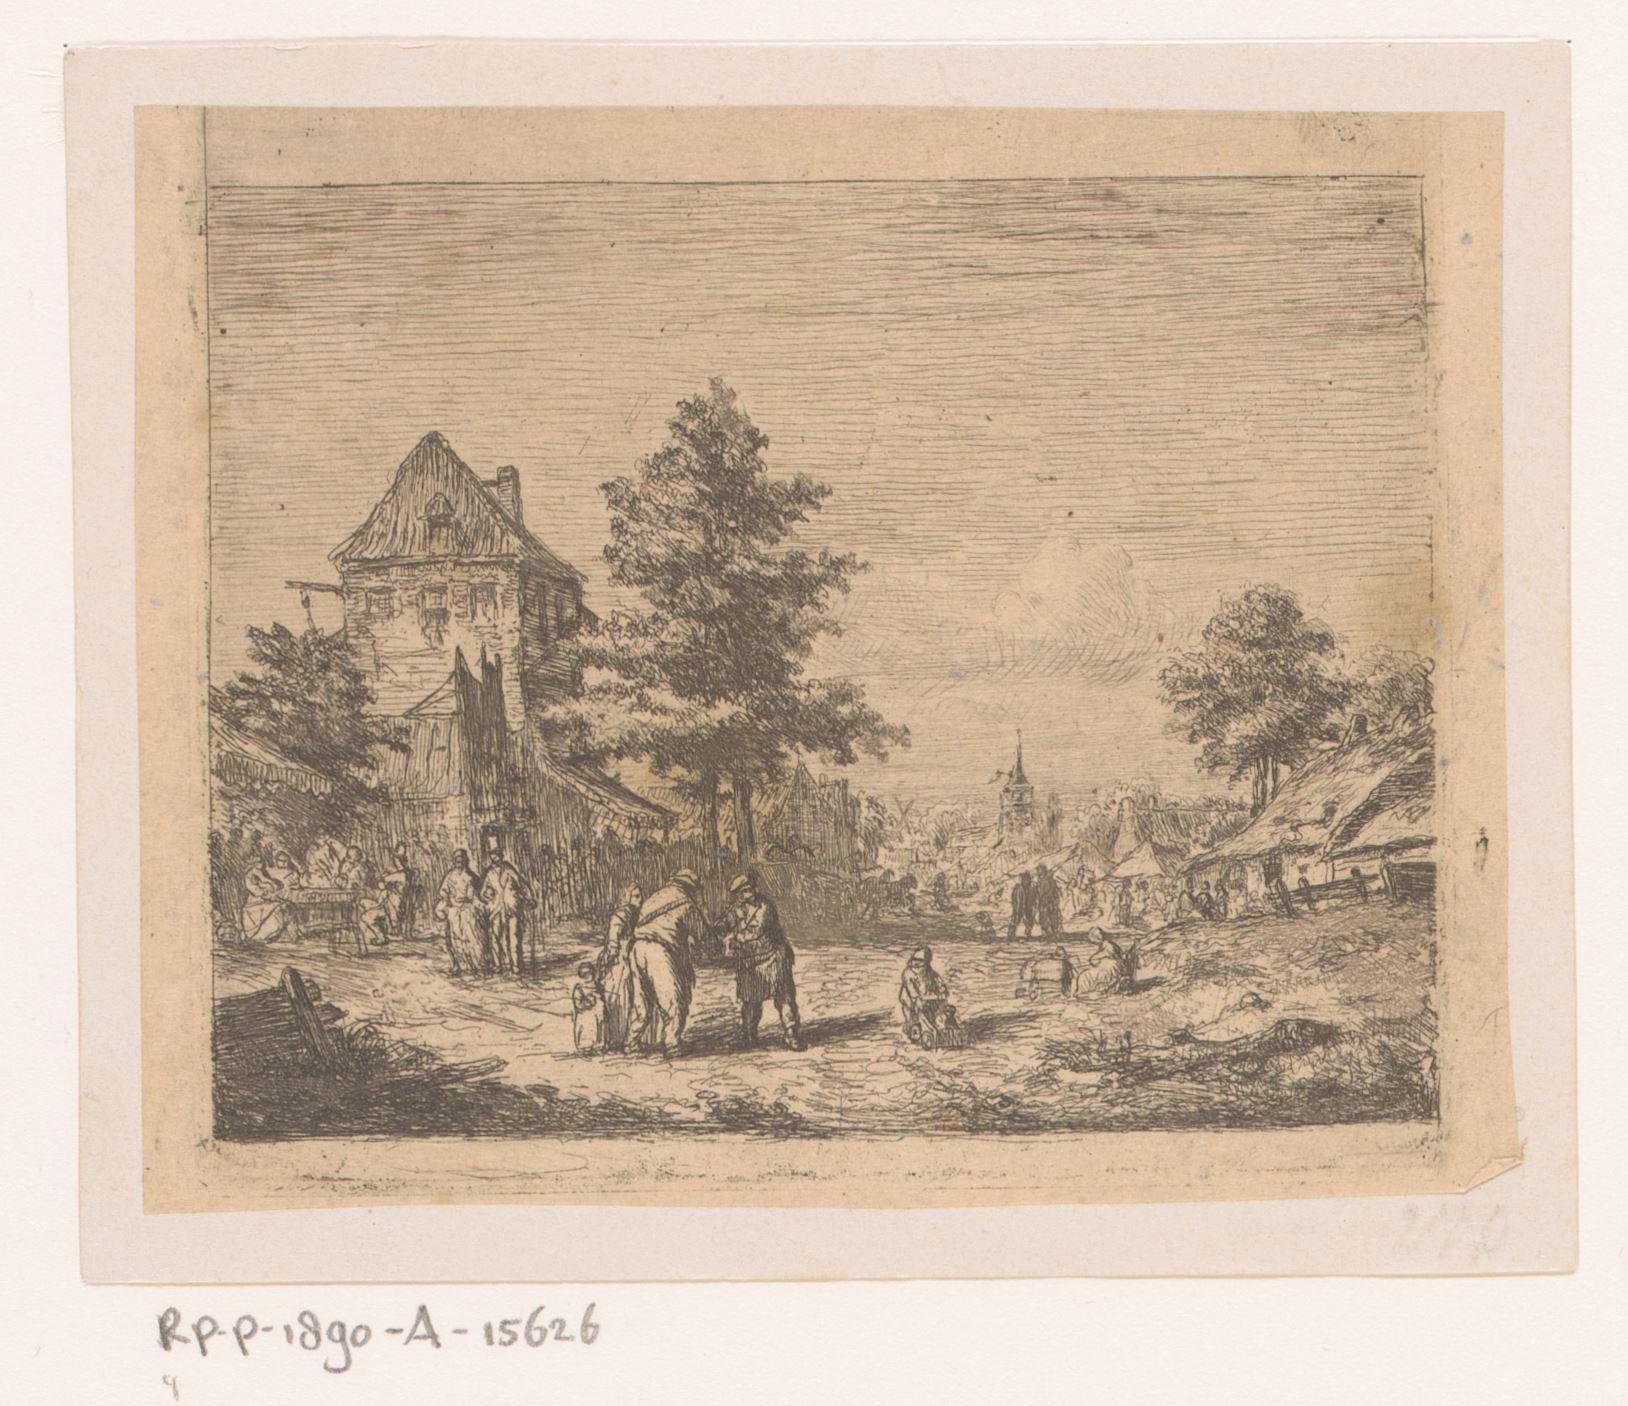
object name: print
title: Dorpsgezicht met veel mensen op straat en een kerk op de achtergrond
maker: florent nicolas crabeels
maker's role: print maker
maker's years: 1829-1896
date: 1849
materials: paper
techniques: etching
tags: village, public festivities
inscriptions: collector's mark: Lugt 2228